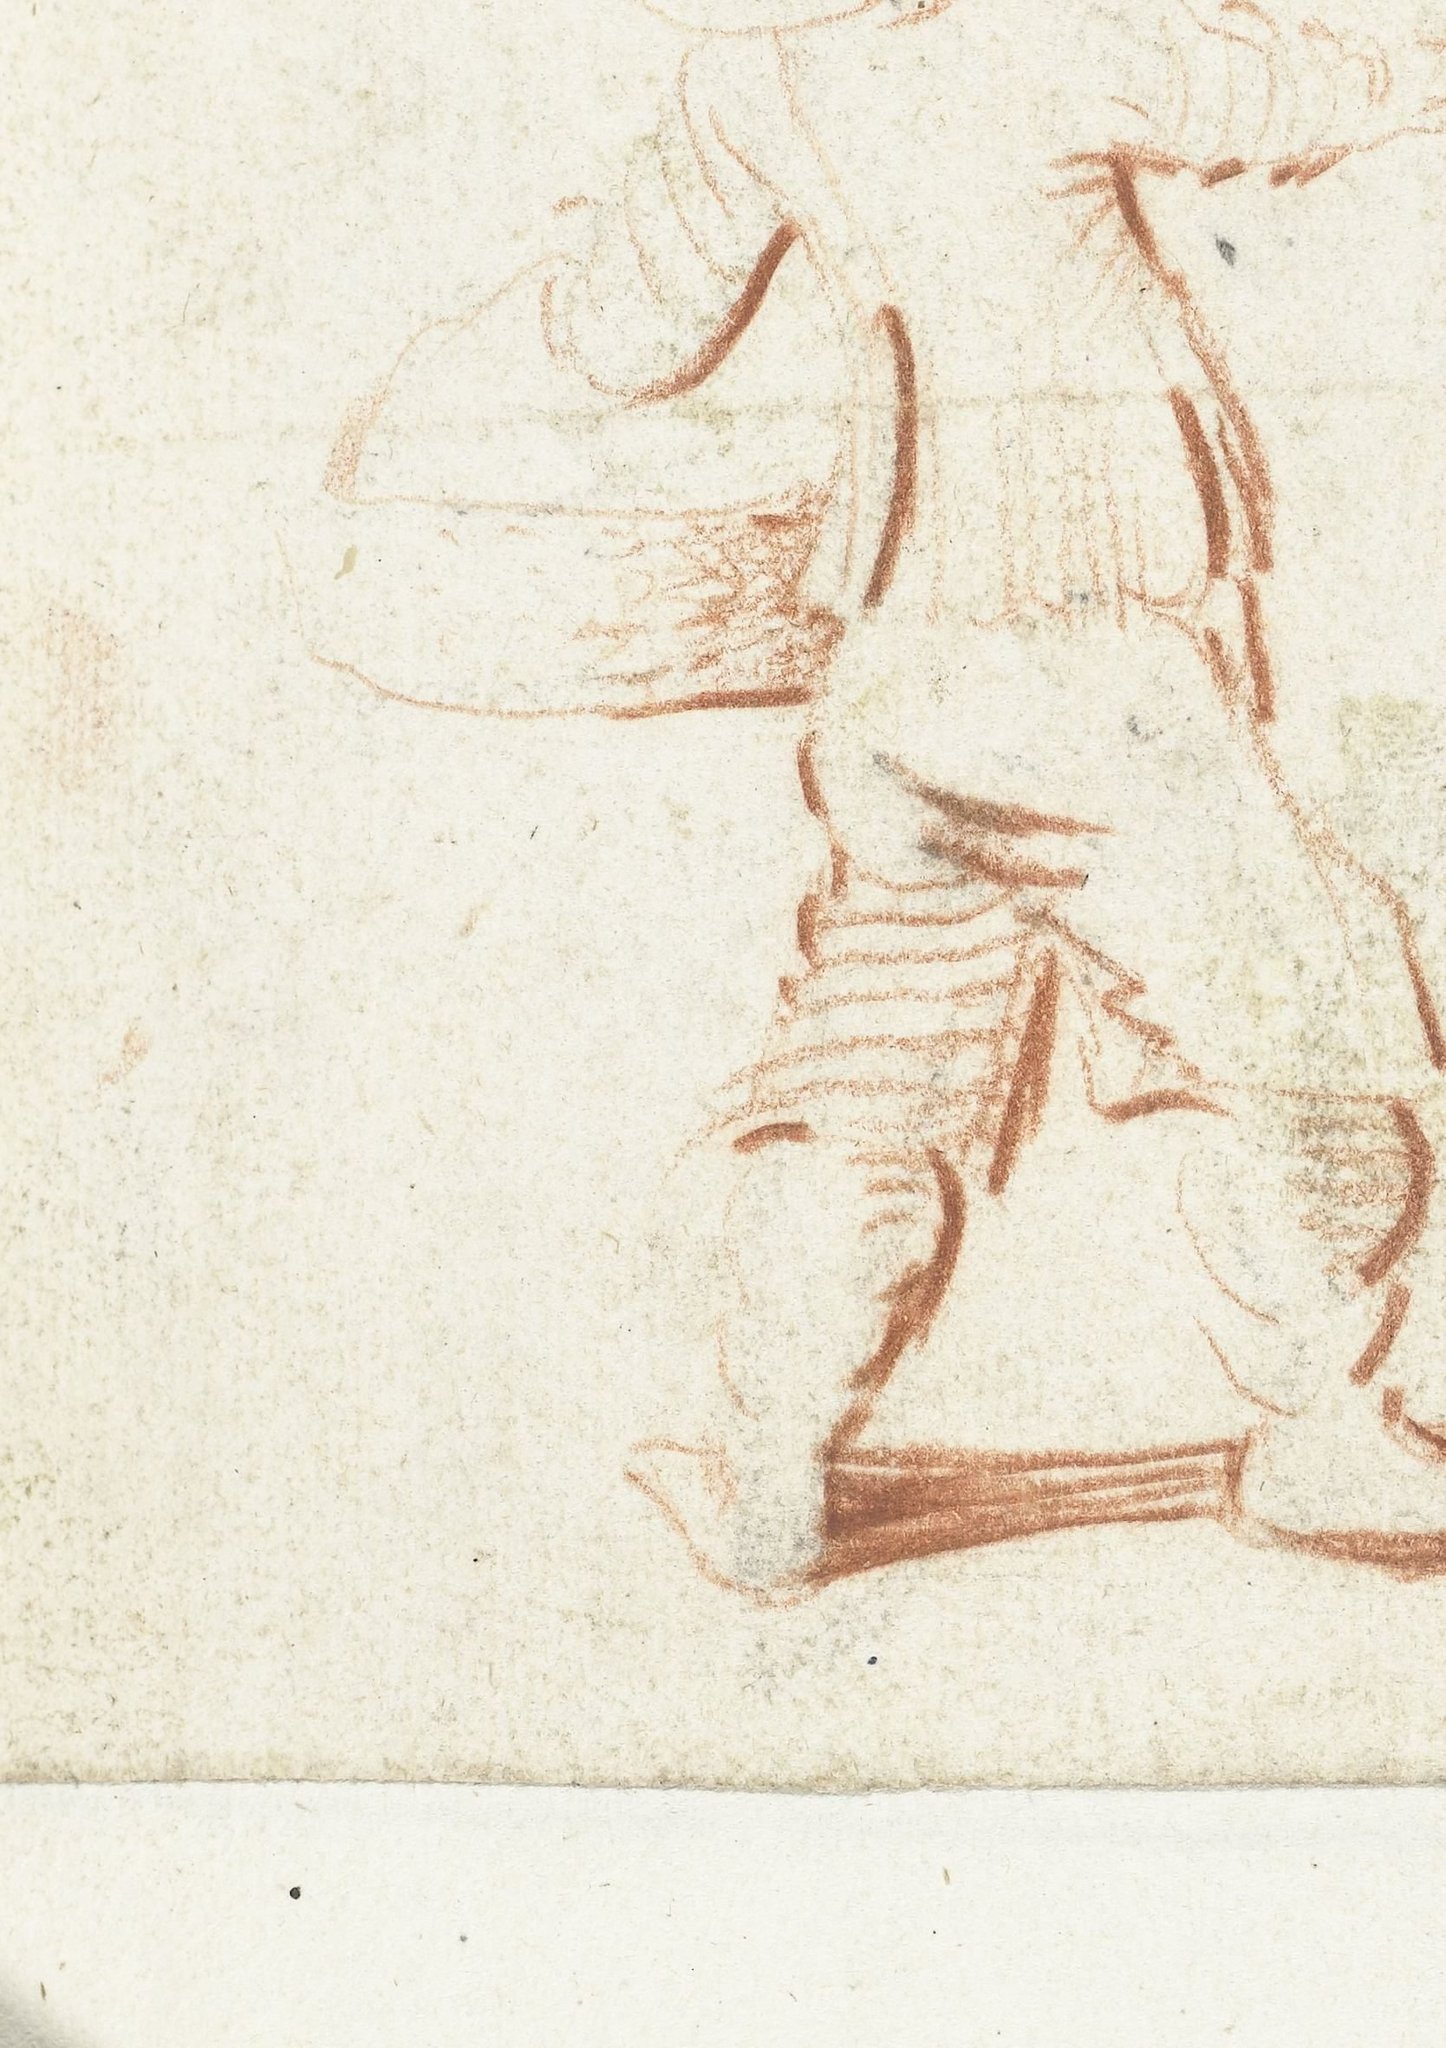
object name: drawing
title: Jongen met mand, van achteren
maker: harmen ter borch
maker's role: draughtsman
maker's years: 1638-1677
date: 1649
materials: chalk, paper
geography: zwolle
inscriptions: annotation: ‘Har[men] ter Borch. inv[n]tor de[n] 10.April 1649’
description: Tekening naast twee andere tekeningen in het Familie-plakboek geplakt.